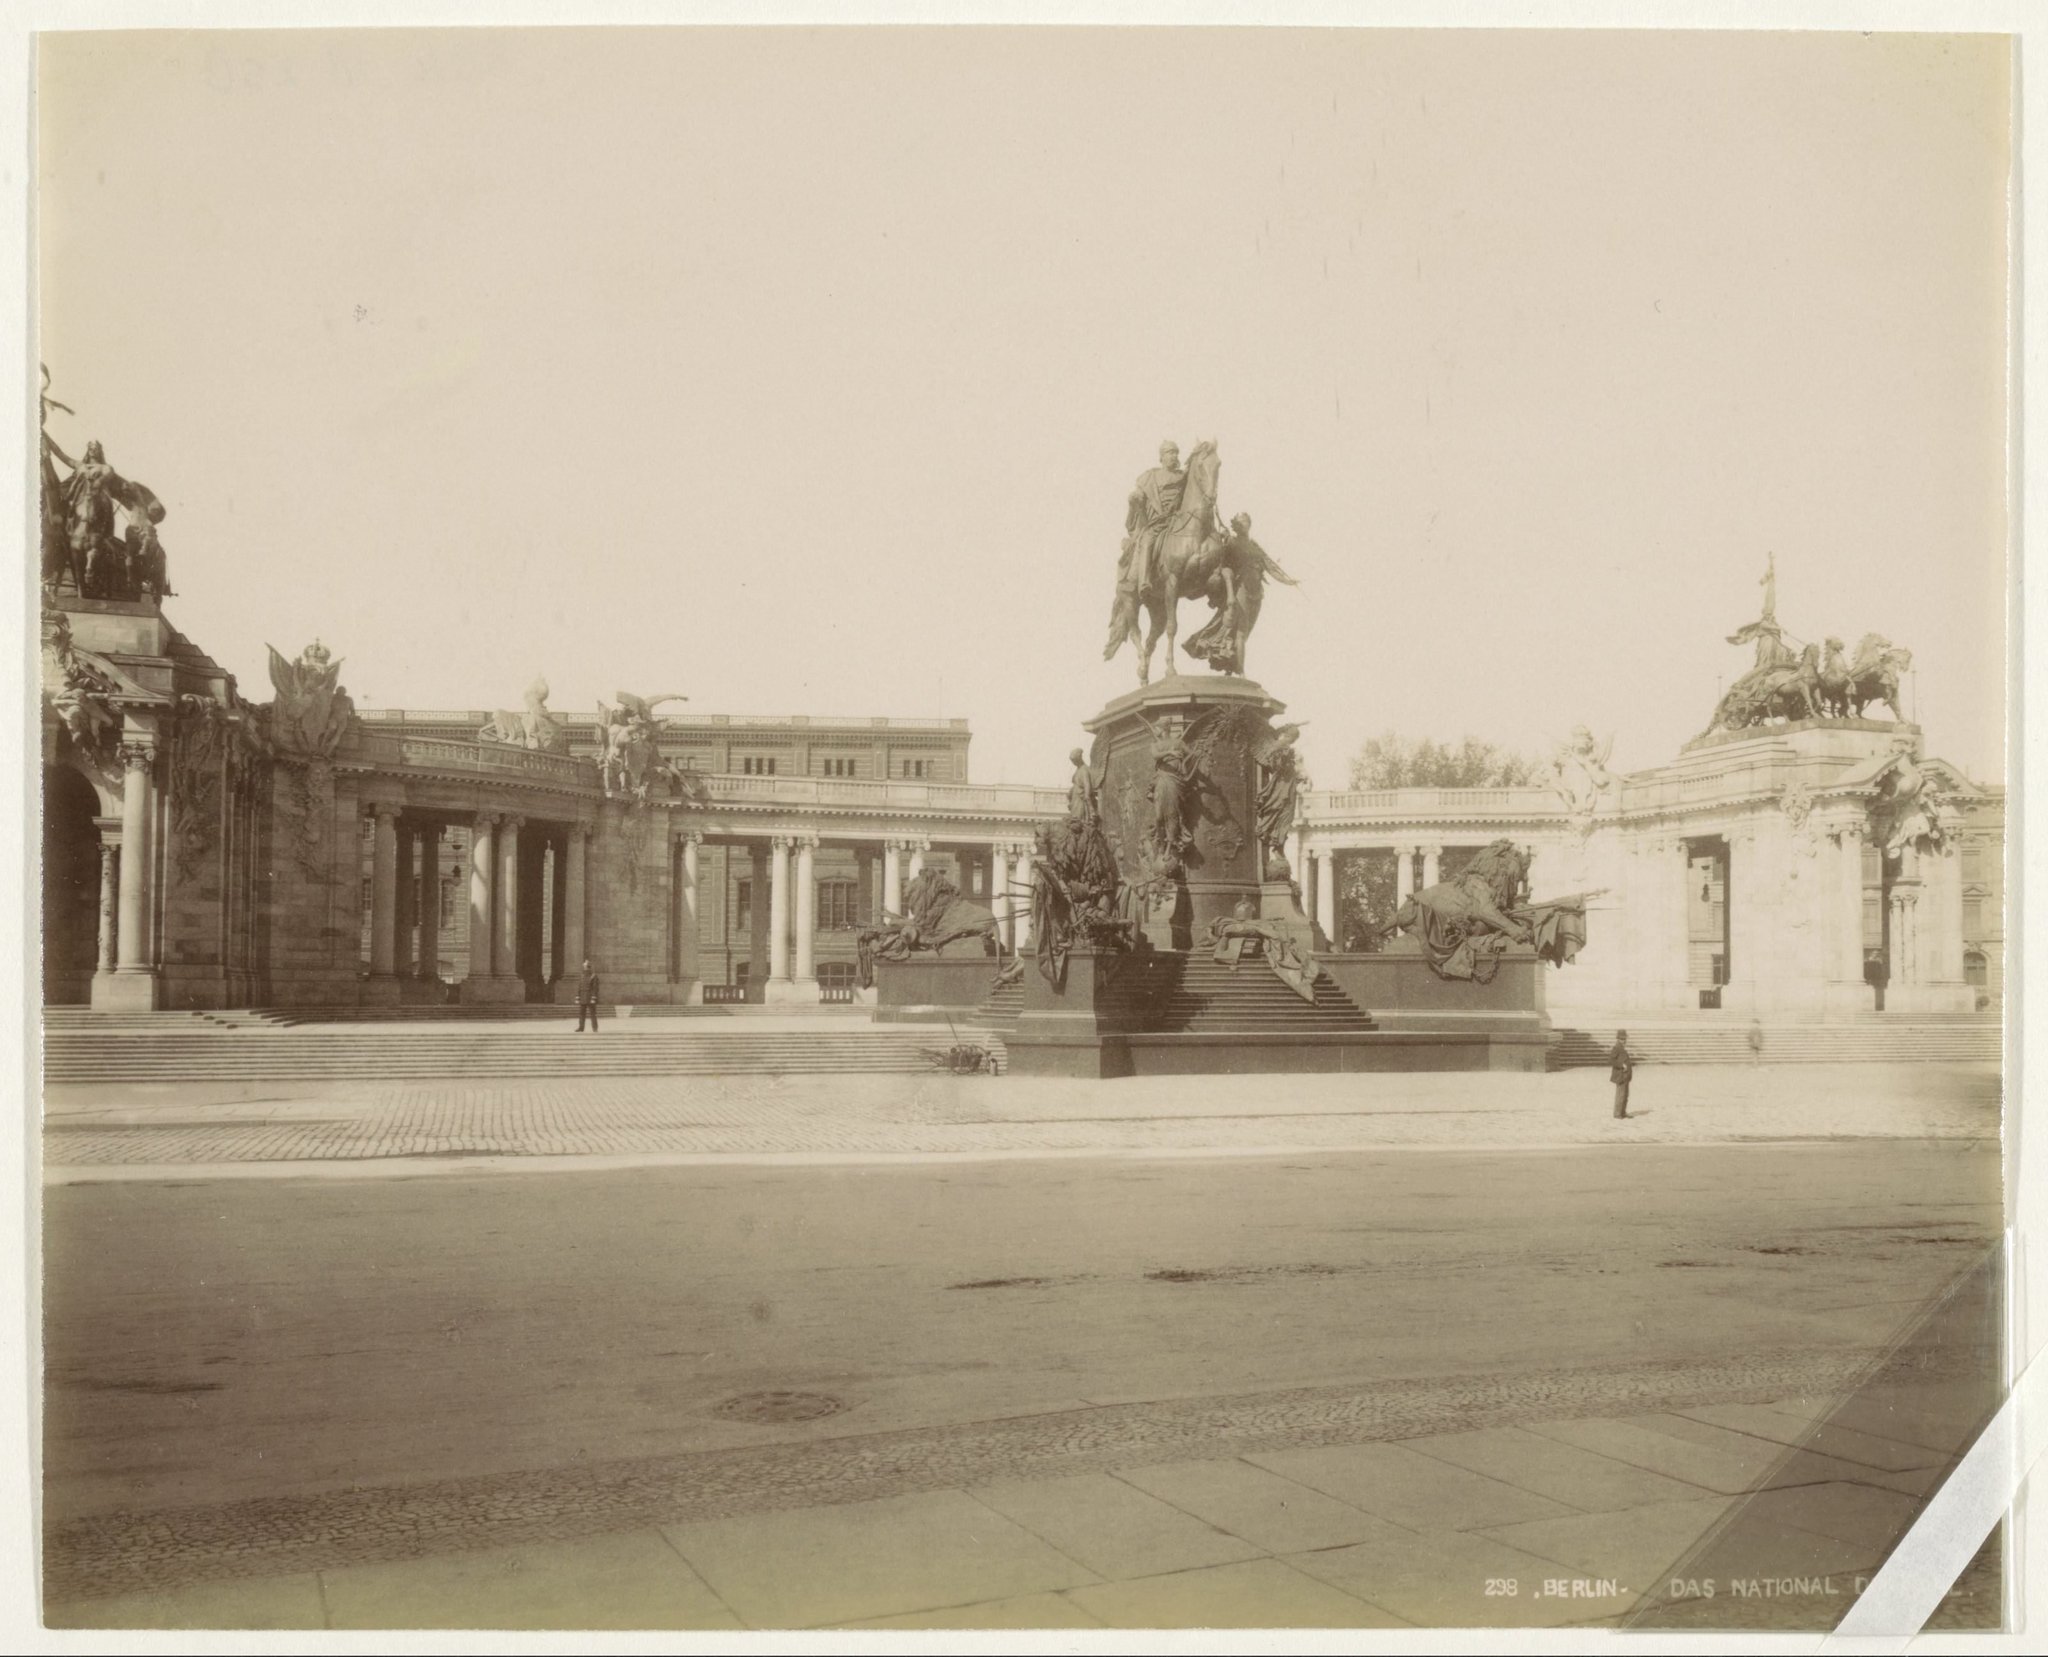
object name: photograph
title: Berlin. Das National Denkmal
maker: friedrich albert schwartz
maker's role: fotograaf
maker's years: 1836-1906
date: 1898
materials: paper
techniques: albumen print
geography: berlin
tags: berlin, wilhelm i (keizer van duitsland), monument, statue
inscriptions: title: ‘298. Berlin. Das National Denkmal’, check stamp: ‘Artist.-Photogr. Gesellschaft/ F. Albert/ Berlin-W.’